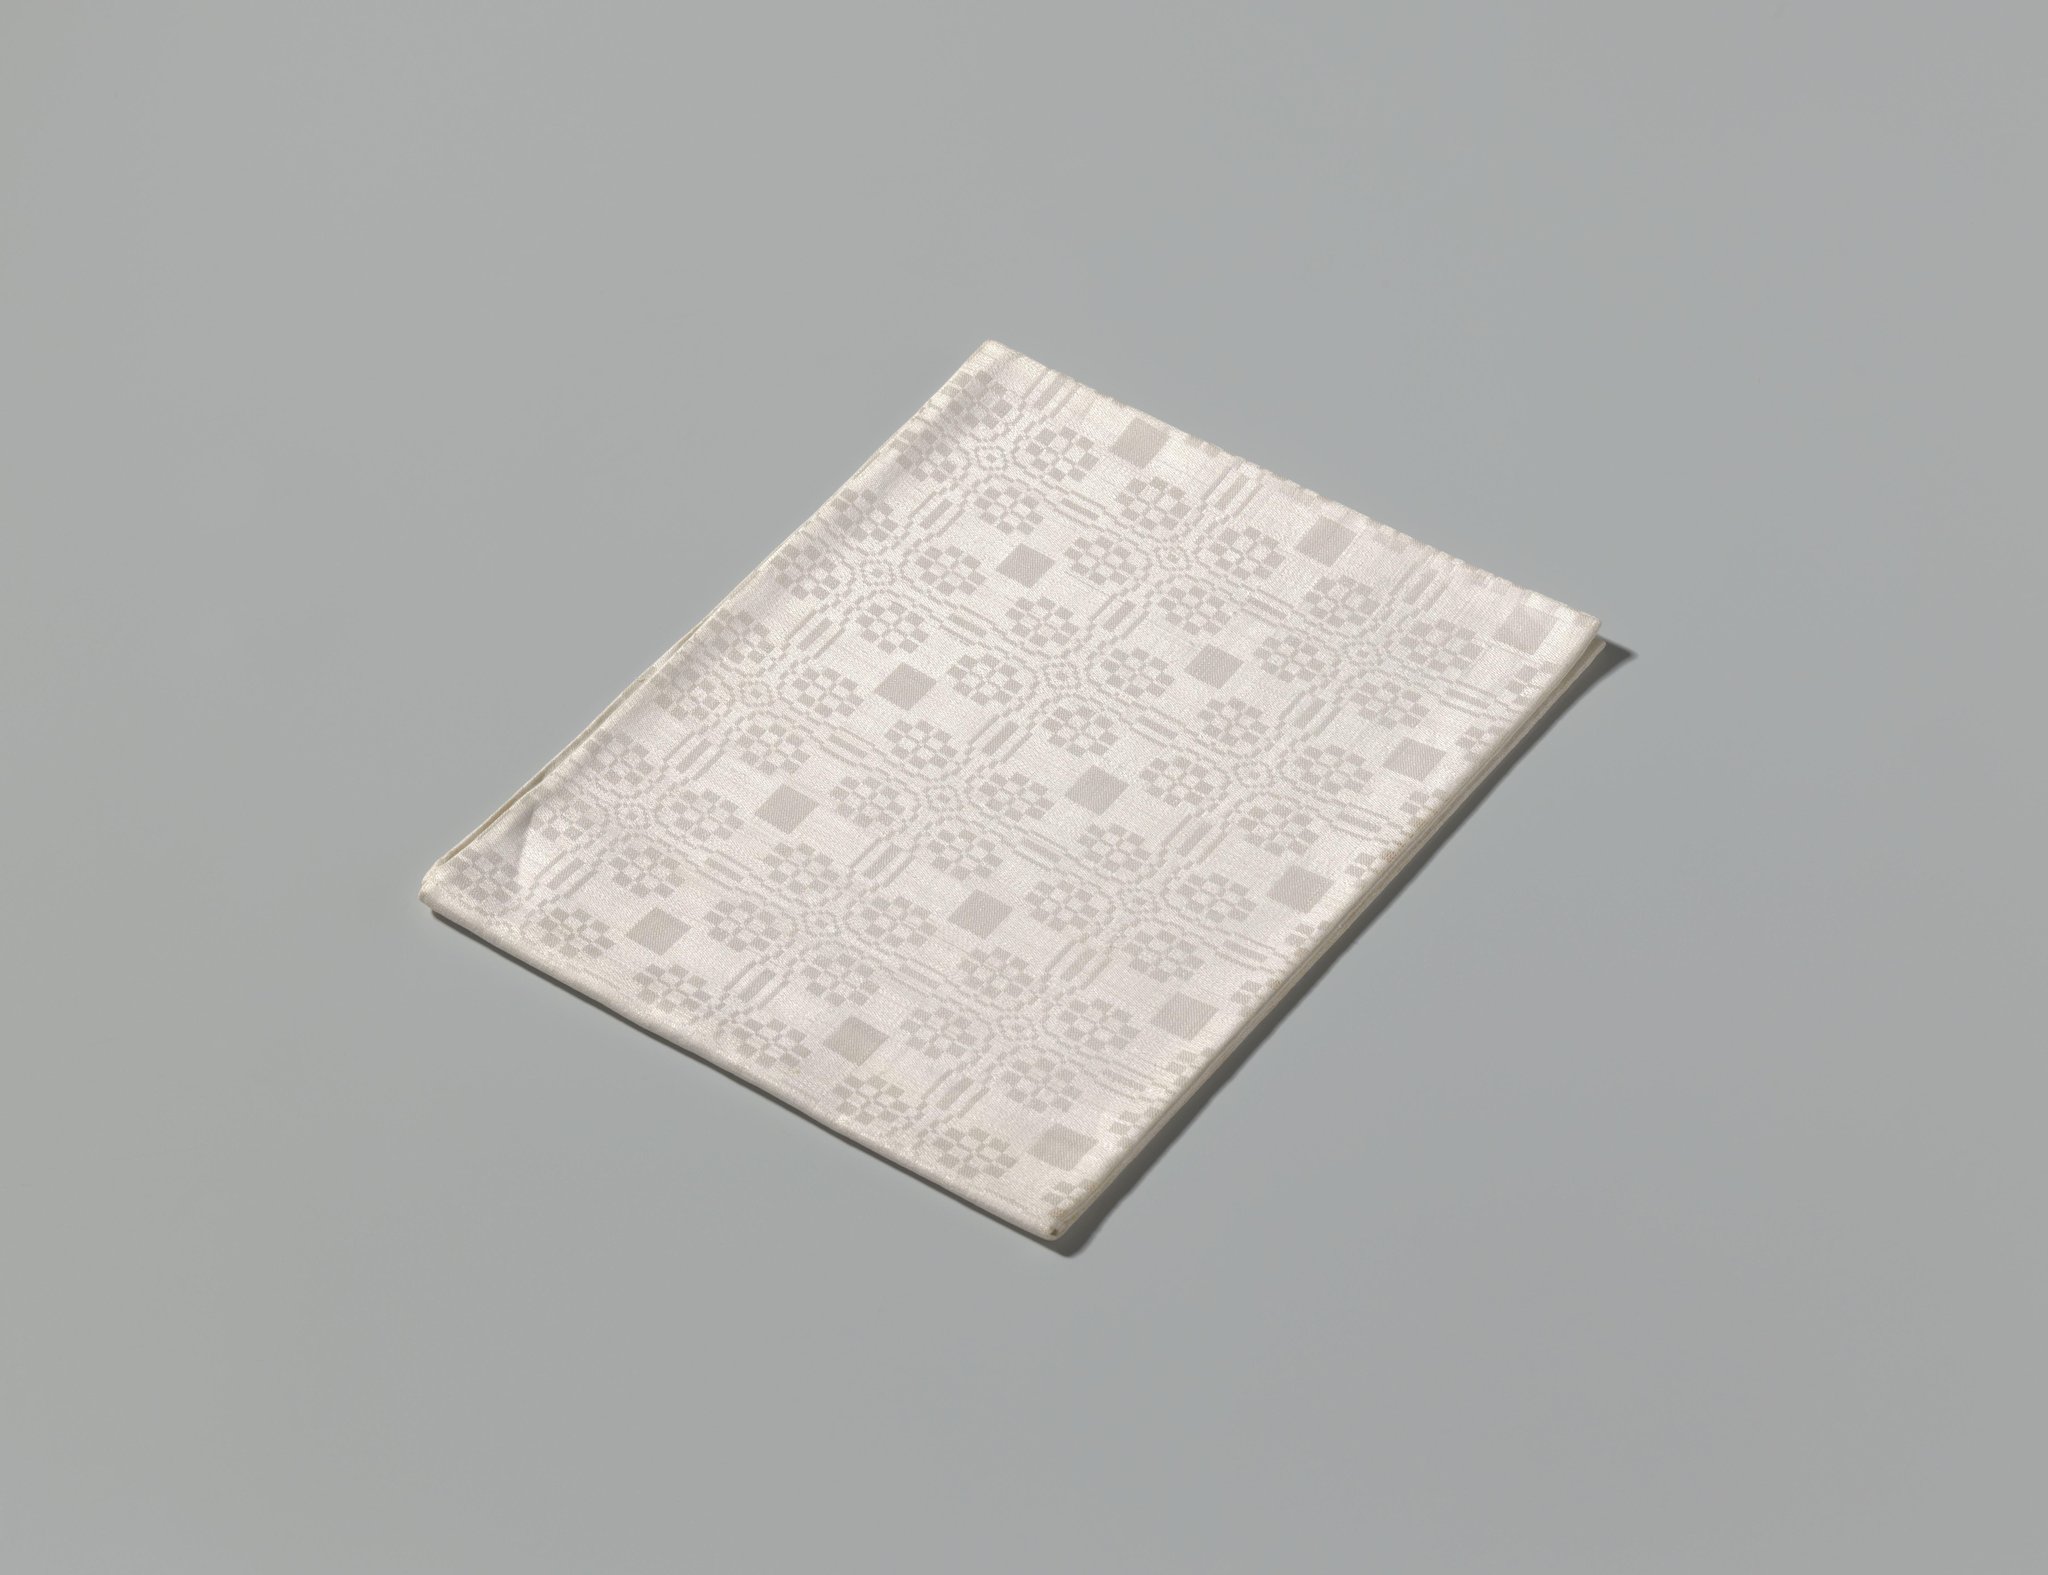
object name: napkin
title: Servet van linnen met pellenpatroon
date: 1767-1816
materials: linen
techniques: peeled fabric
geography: northern netherlands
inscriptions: : ‘WS 8’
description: wit linnen servet met pellen patroon, merk WS 8